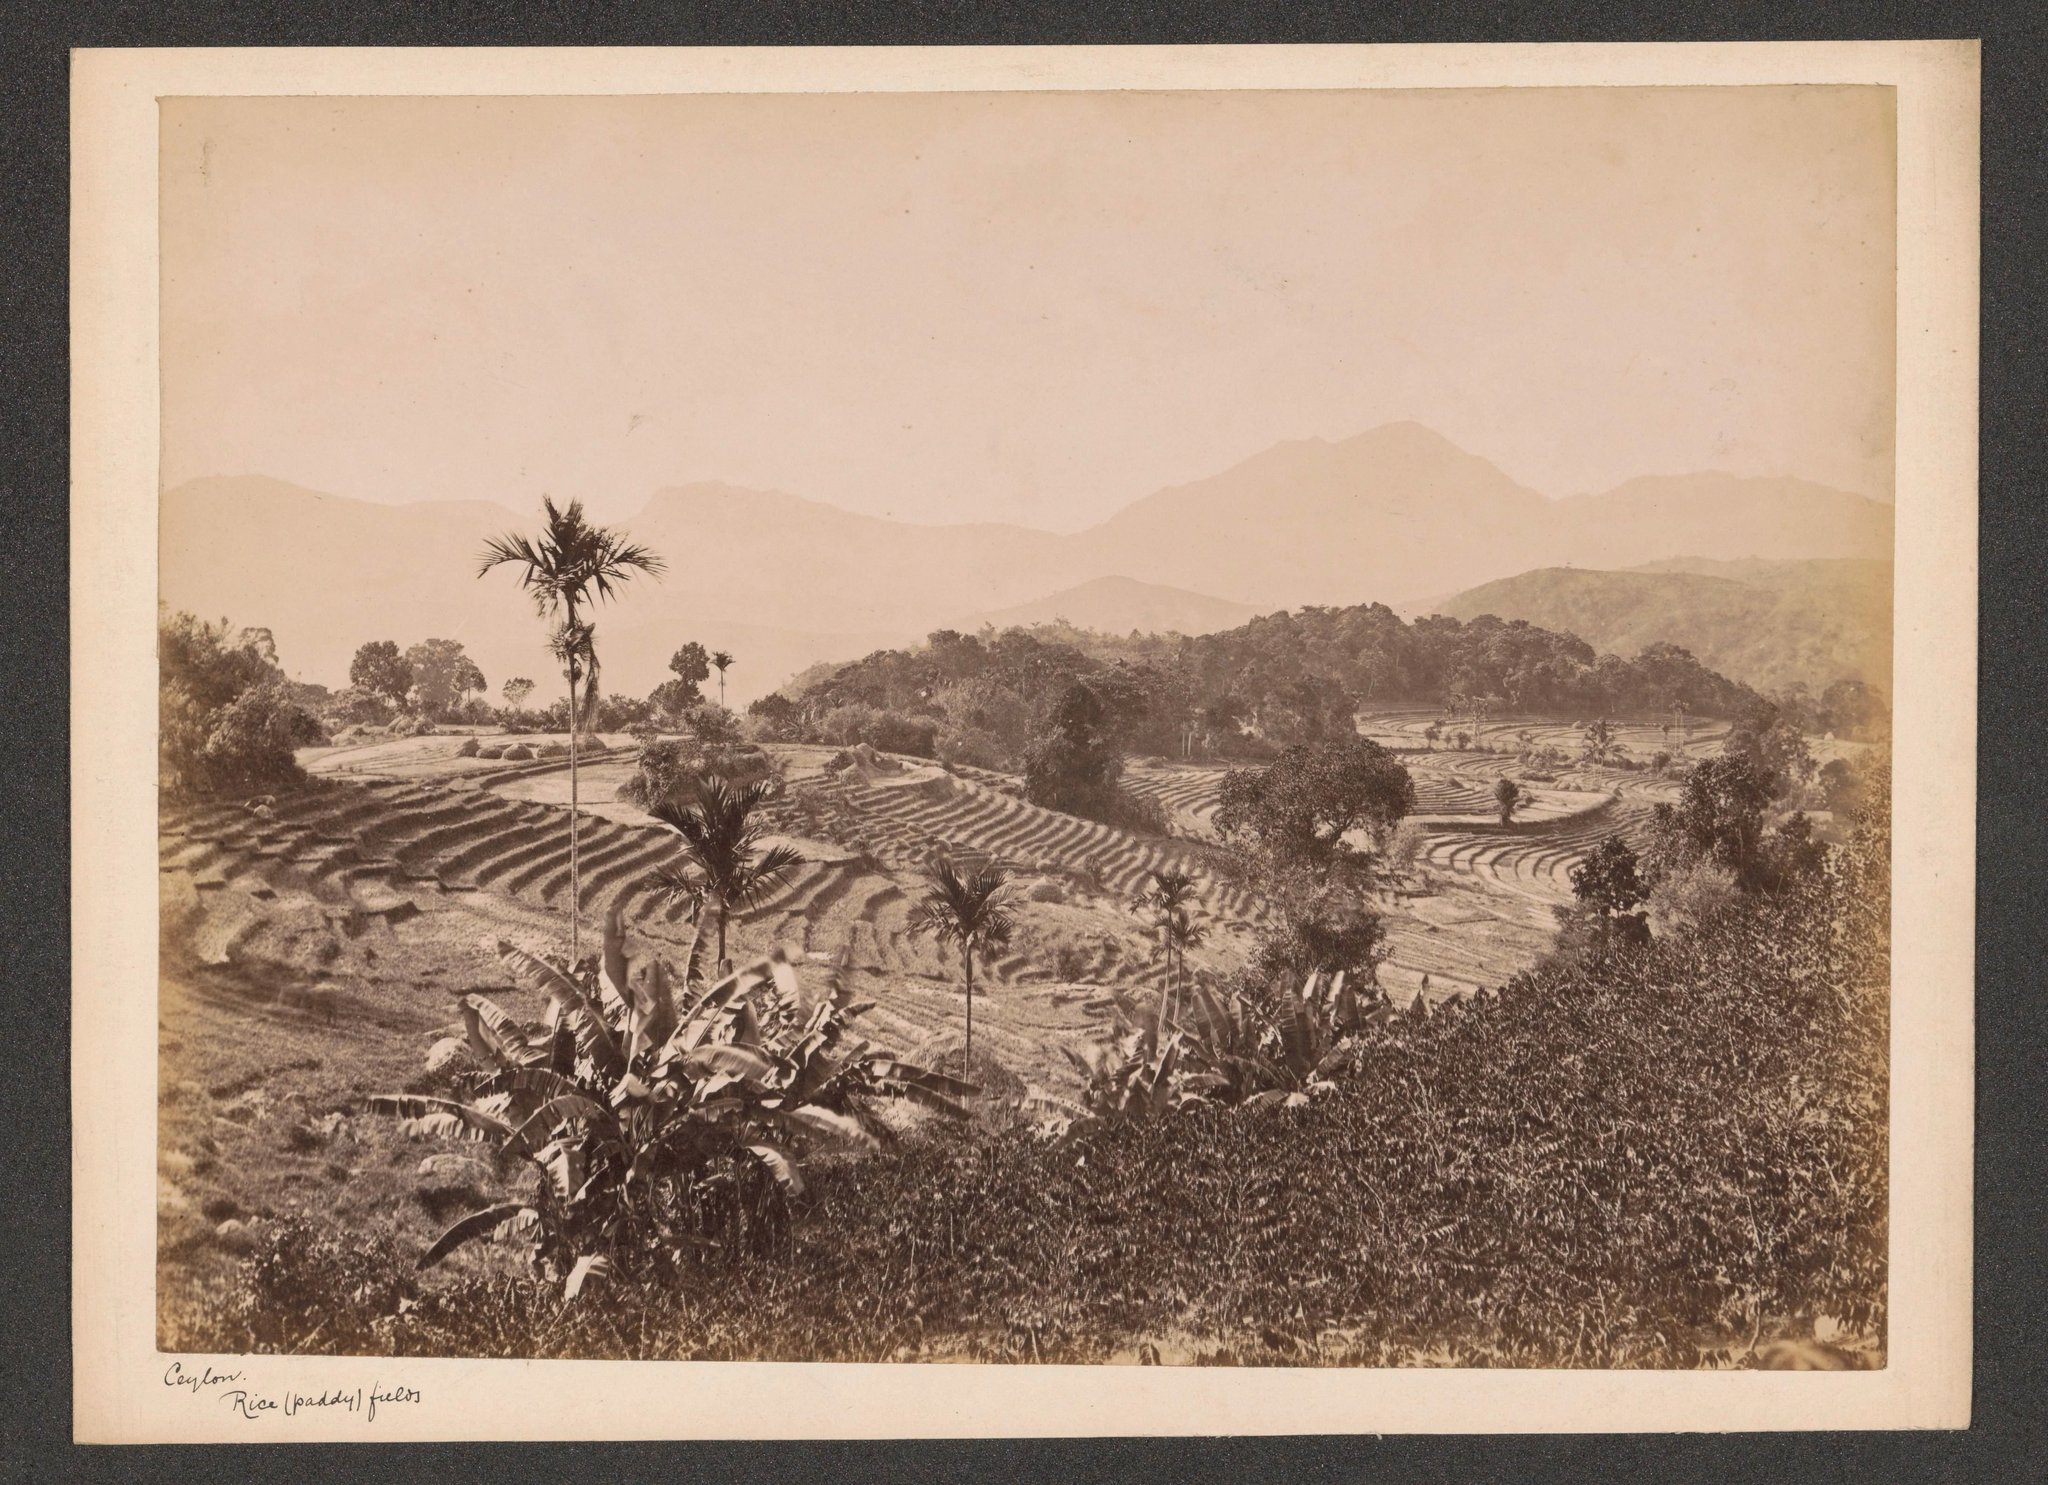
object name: photograph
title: Terraced fields of rice, Sri Lanka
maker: Anonymous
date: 1860-1890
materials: cardboard, paper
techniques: albumen print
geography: sri lanka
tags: sawahs, rice paddies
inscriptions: title: ‘Ceylon./ Rice (paddy) fields’, number: ‘38’